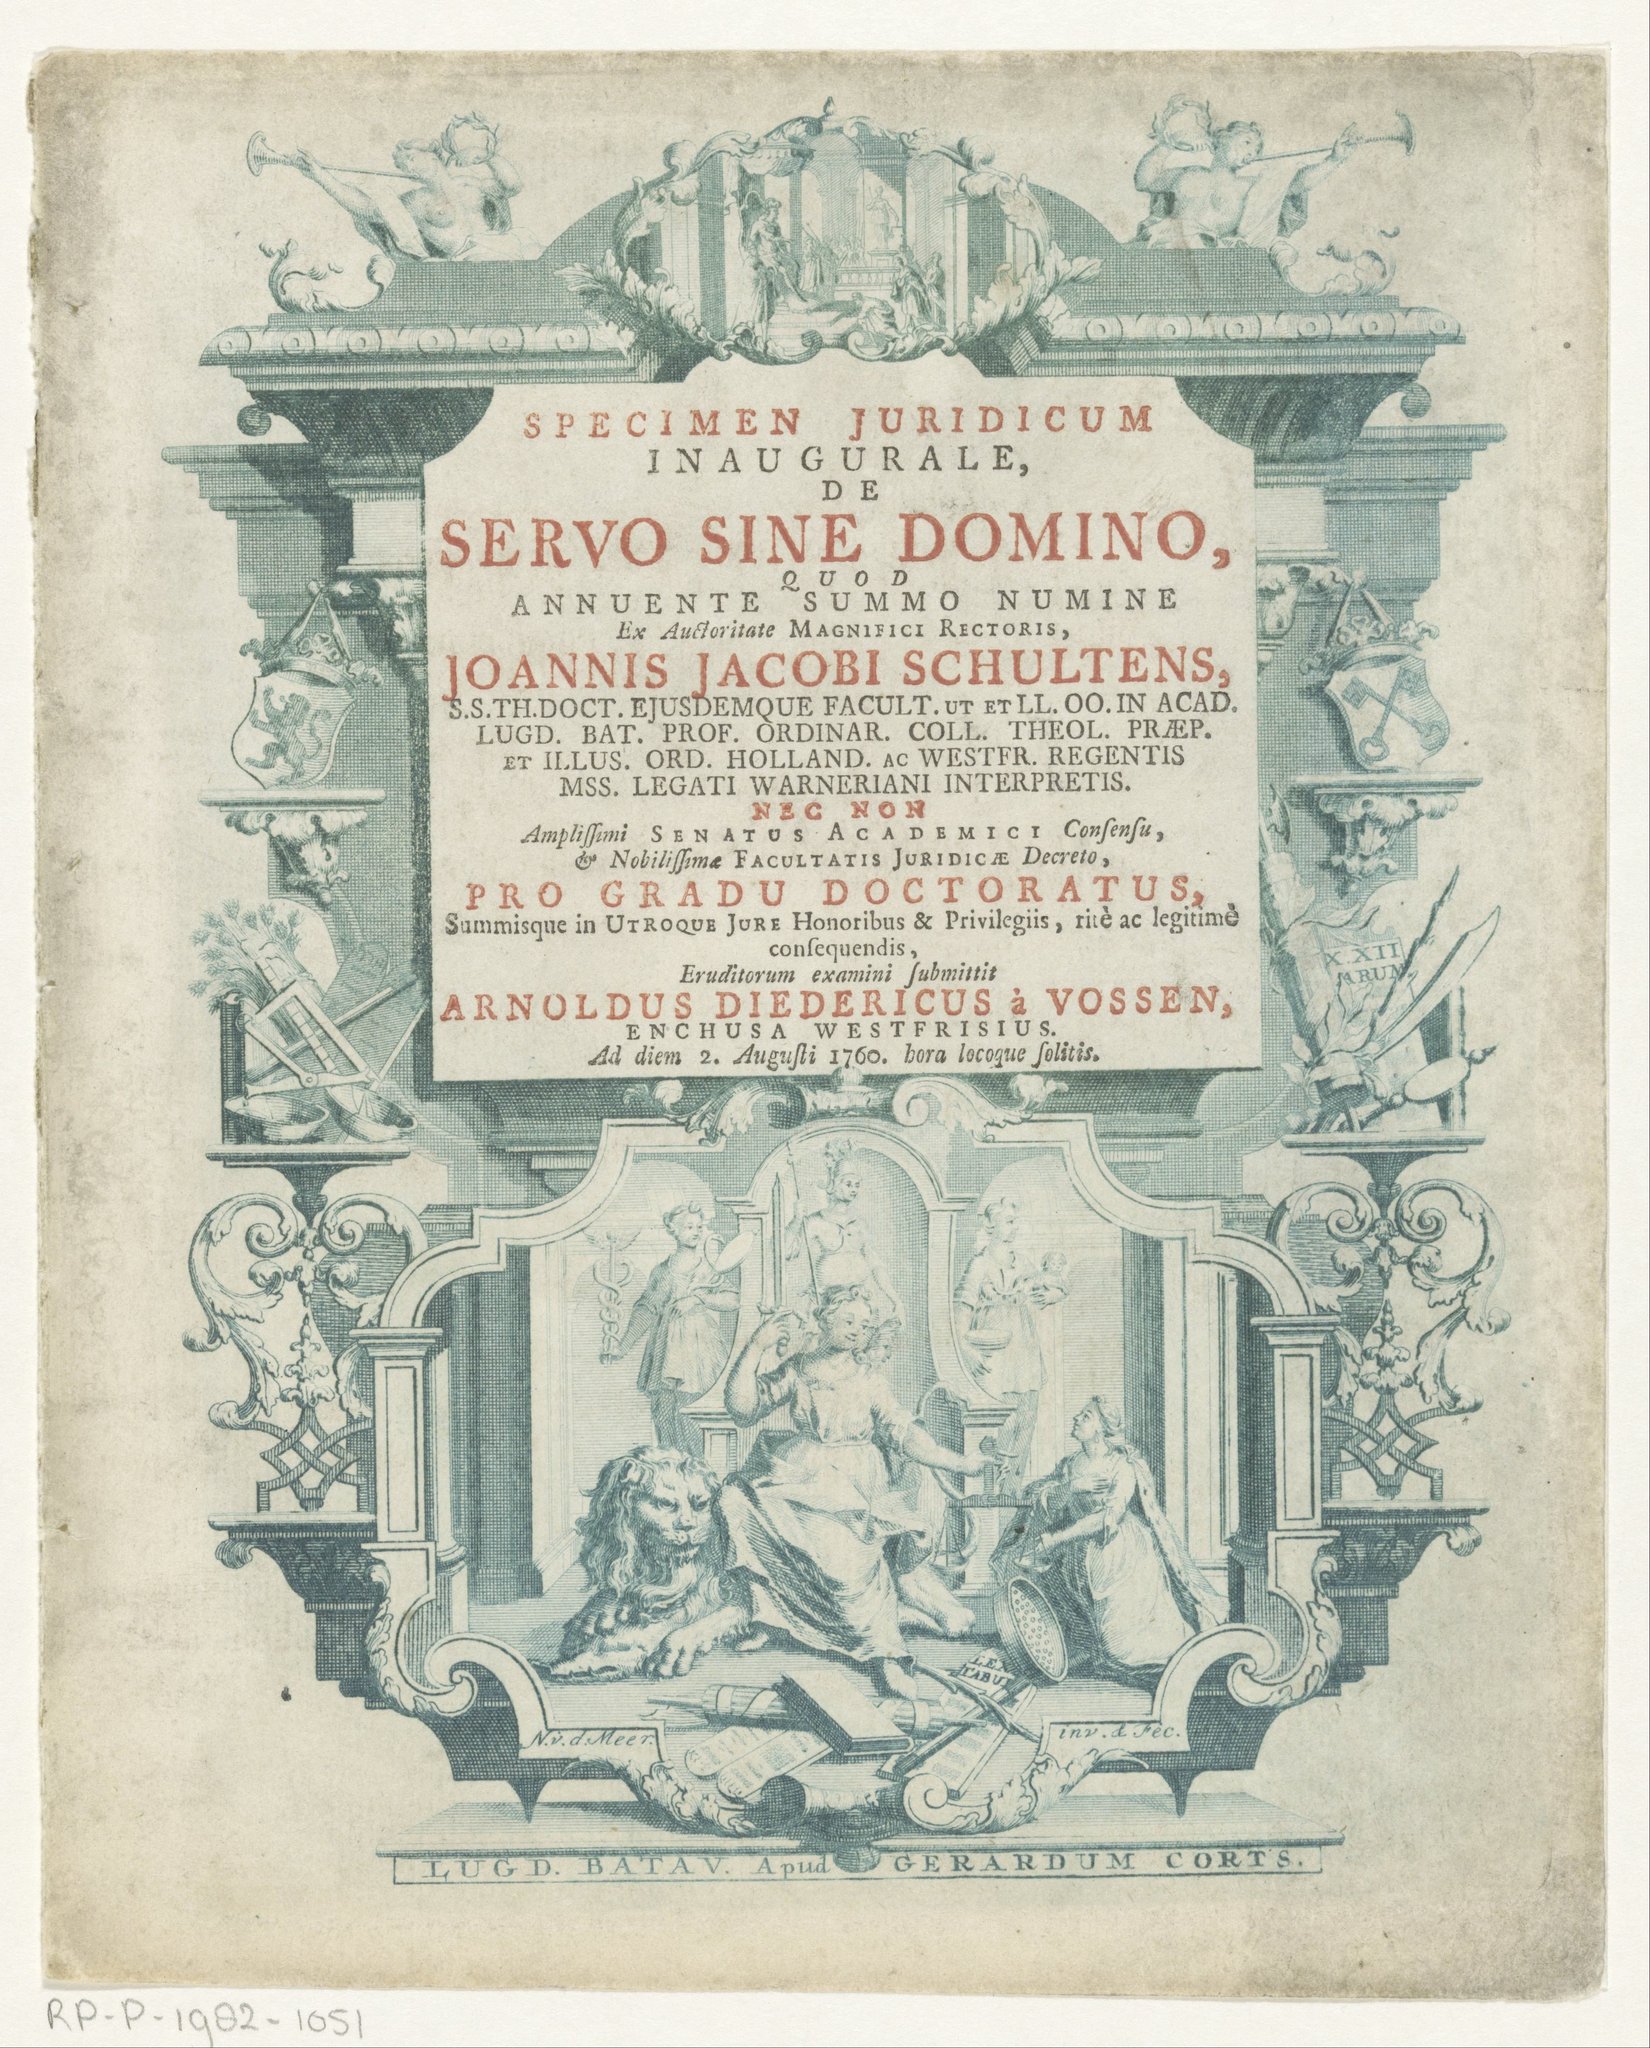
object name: print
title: Titelpagina voor: Arnold Diederik van Vossen, Specimen juridicum inaugurale de servo sine domino, 1760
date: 1760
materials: paper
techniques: engraving, etching, letterpress printing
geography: leiden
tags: ornaments ~ art (+ framing decorations), justitia (justice) as roman personification, symbols of particular nations, states, districts, etc.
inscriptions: collector's mark: Lugt 2228, collector's mark: Lugt 2760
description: Een ornamentele omlijsting met wapenschilden, trofeeën en een cartouche met Rechtvaardigheid zittend op de Hollandse leeuw. Achter haar staan Voorzichtigheid met spiegel en slang, Minerva met lans en schild en een allegorische figuur met zuil en hond. Rechts zit een knielende vrouw. Aan de bovenzijde van de omlijsting twee op bazuinen blazende vrouwen met lauwerkrans en een cartouche met figuren knielend en staand voor een tronende man.